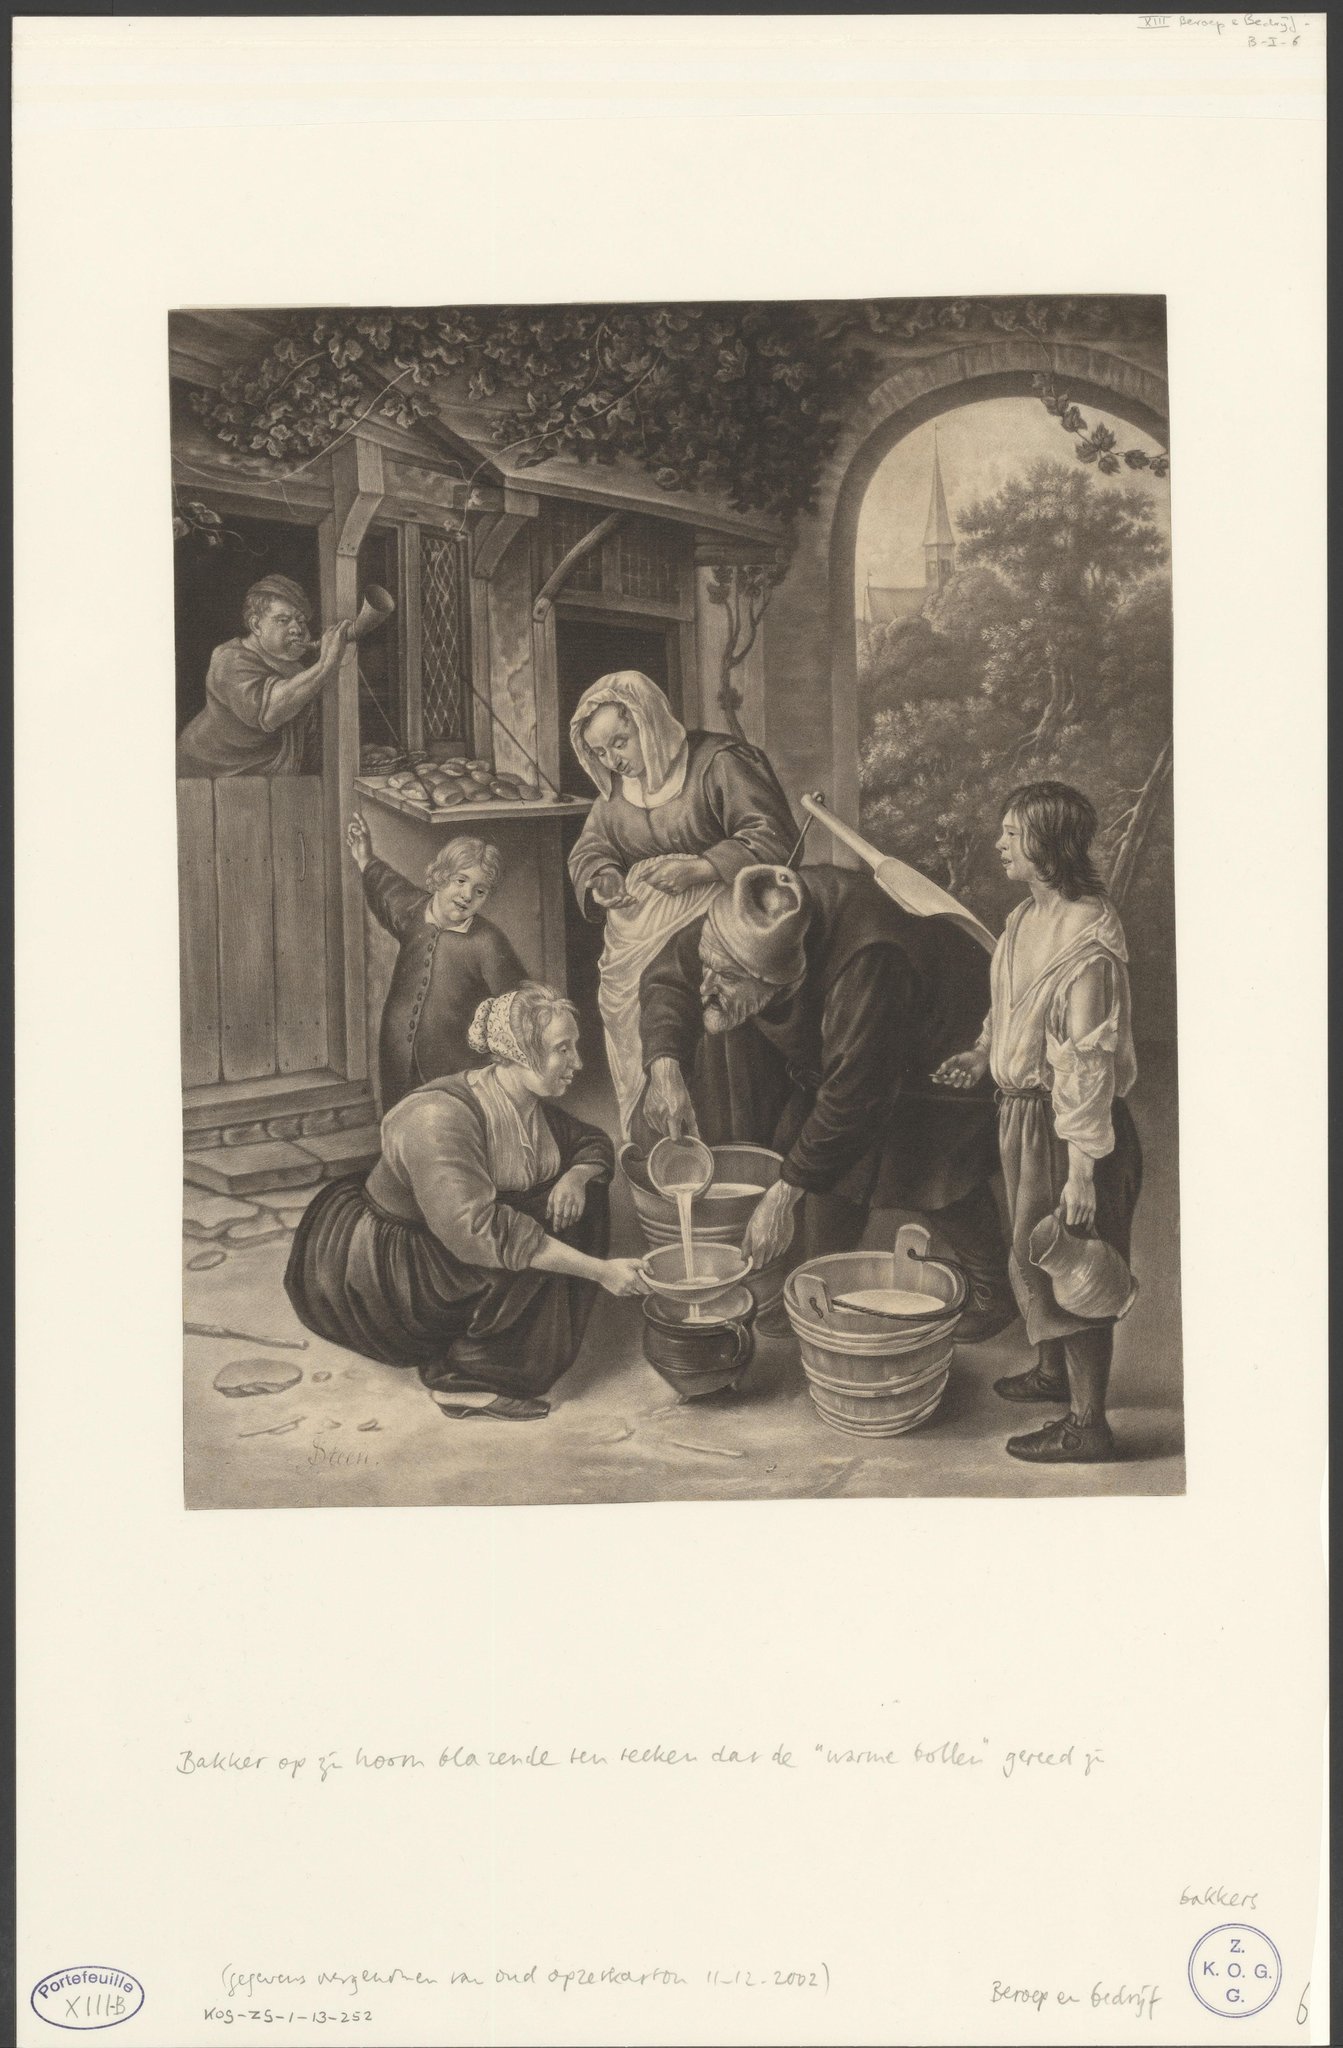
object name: print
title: Melkboer schenkt melk voor een bakker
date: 1779-1791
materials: paper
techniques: etching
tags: village, baker, milkmaid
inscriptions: collector's mark: Lugt 1641, stamp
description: Onderwerpsrubrieken binnen de Atlas Zeden en Gewoonten: Handel, Nijverheid en Verkeer, Beroep en bedrijf, Mannelijk, Eet- en drinkwaren.